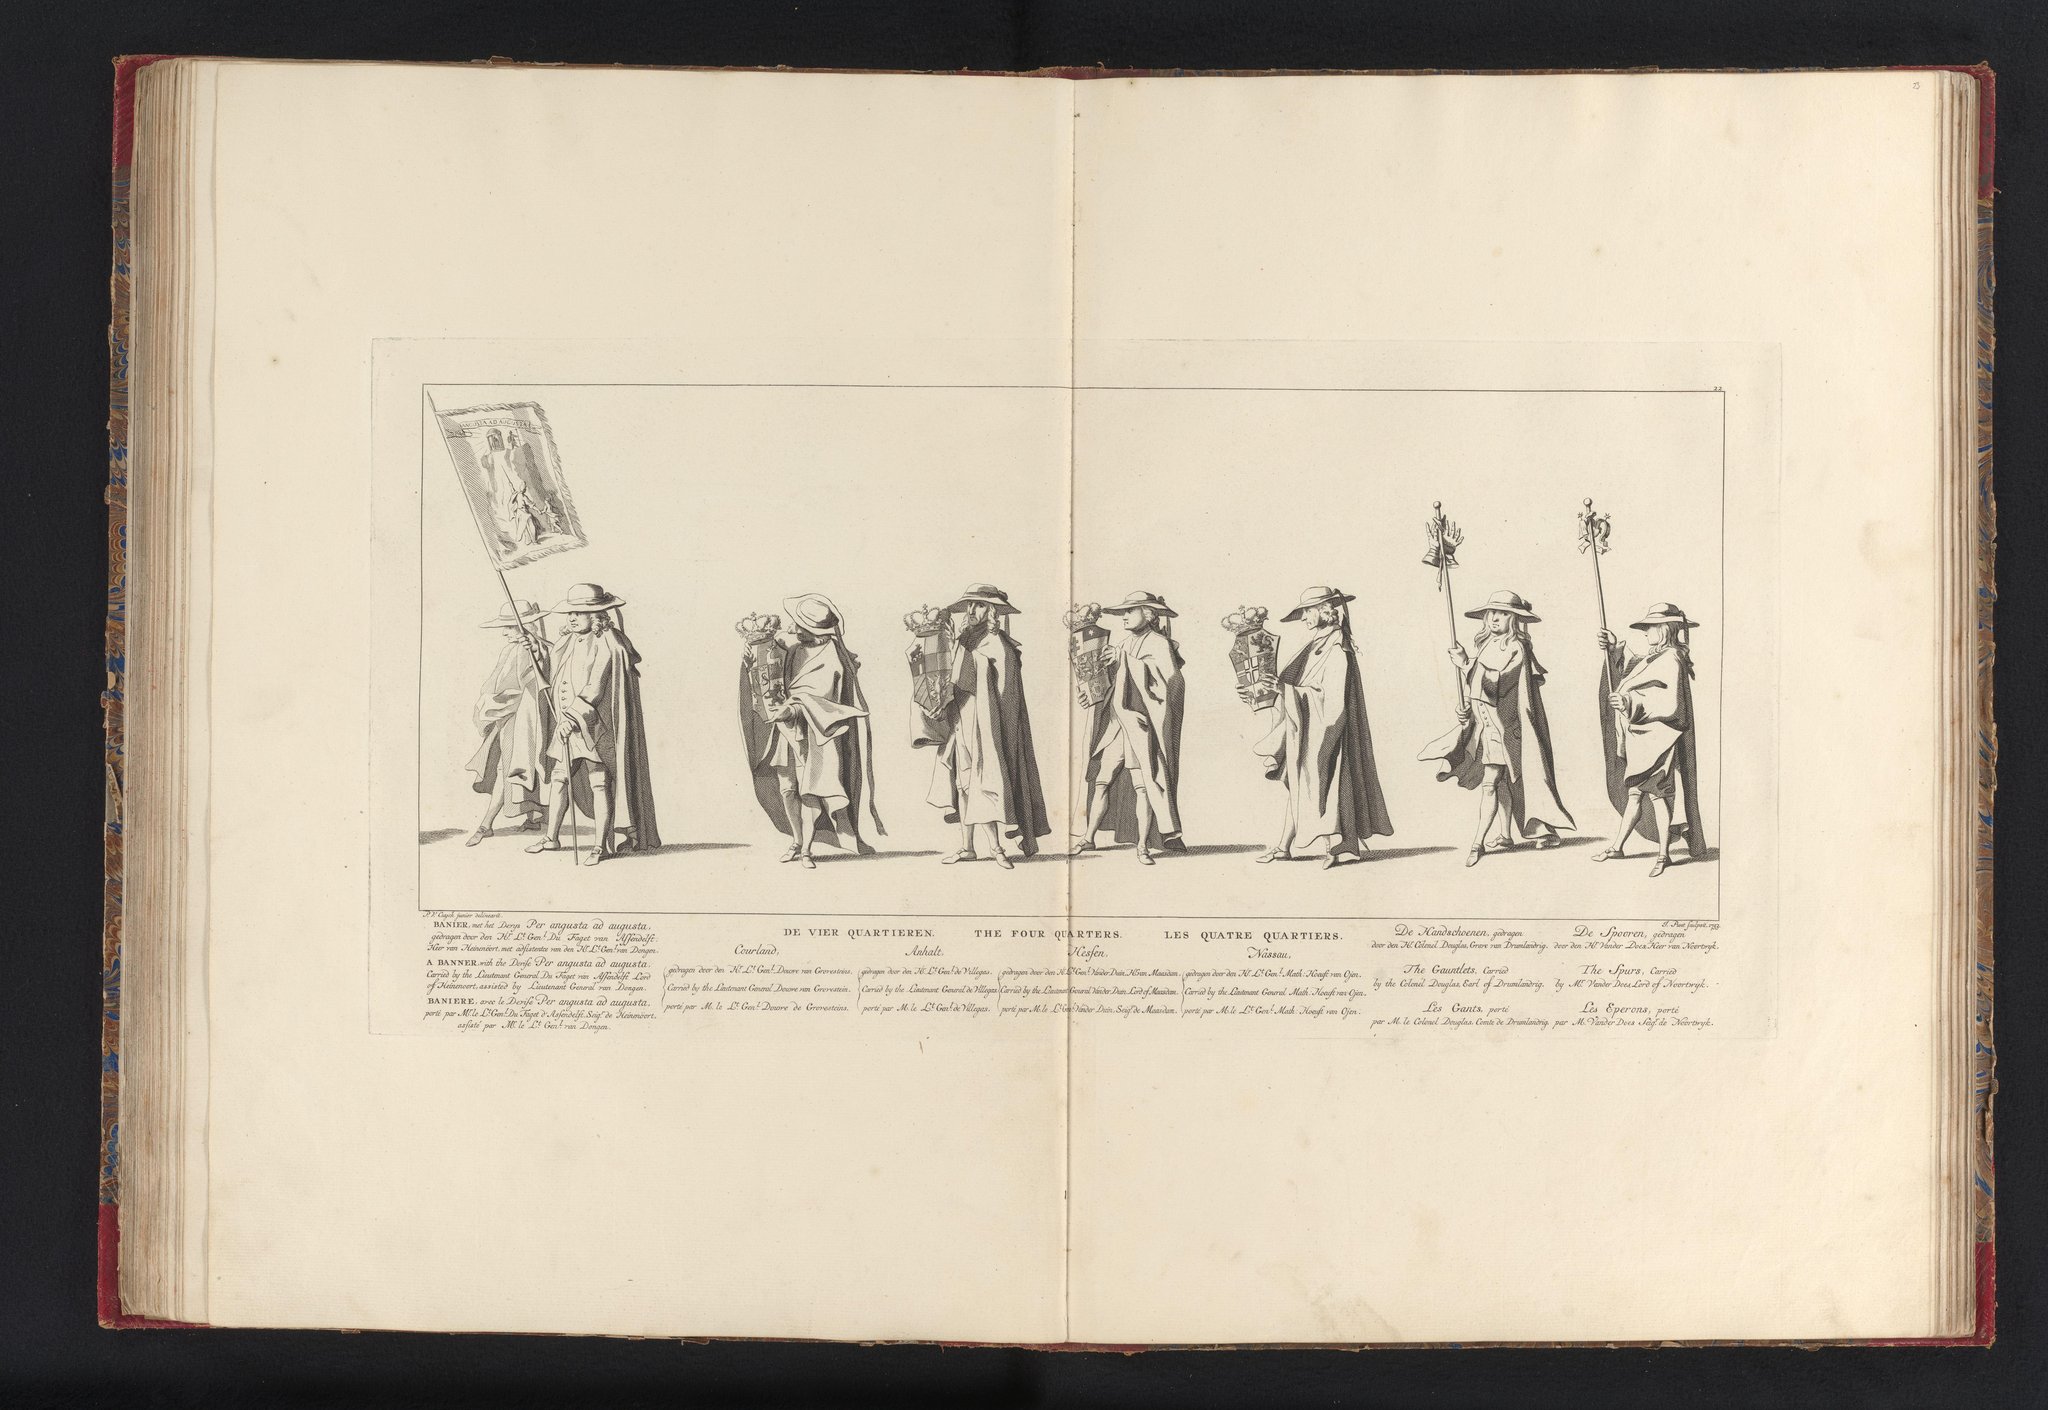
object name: album leaf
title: Banier met het Devys / De Vier Quartieren / De Handschoenen (...)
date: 1753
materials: paper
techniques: engraving, etching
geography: the hague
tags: the hague, willem iv (prins van oranje-nassau), cortege, funeral procession, insignia and symbols of sovereignty (crown, diadem, sceptre, orb, seal, standard, cloak, pectoral), delft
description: Een banier en de dragers van de vier kwartieren van het stadhouderlijk wapen. In de marge een onderschrift in het Nederlands, Frans en Engels. De prent maakt deel uit van een album.